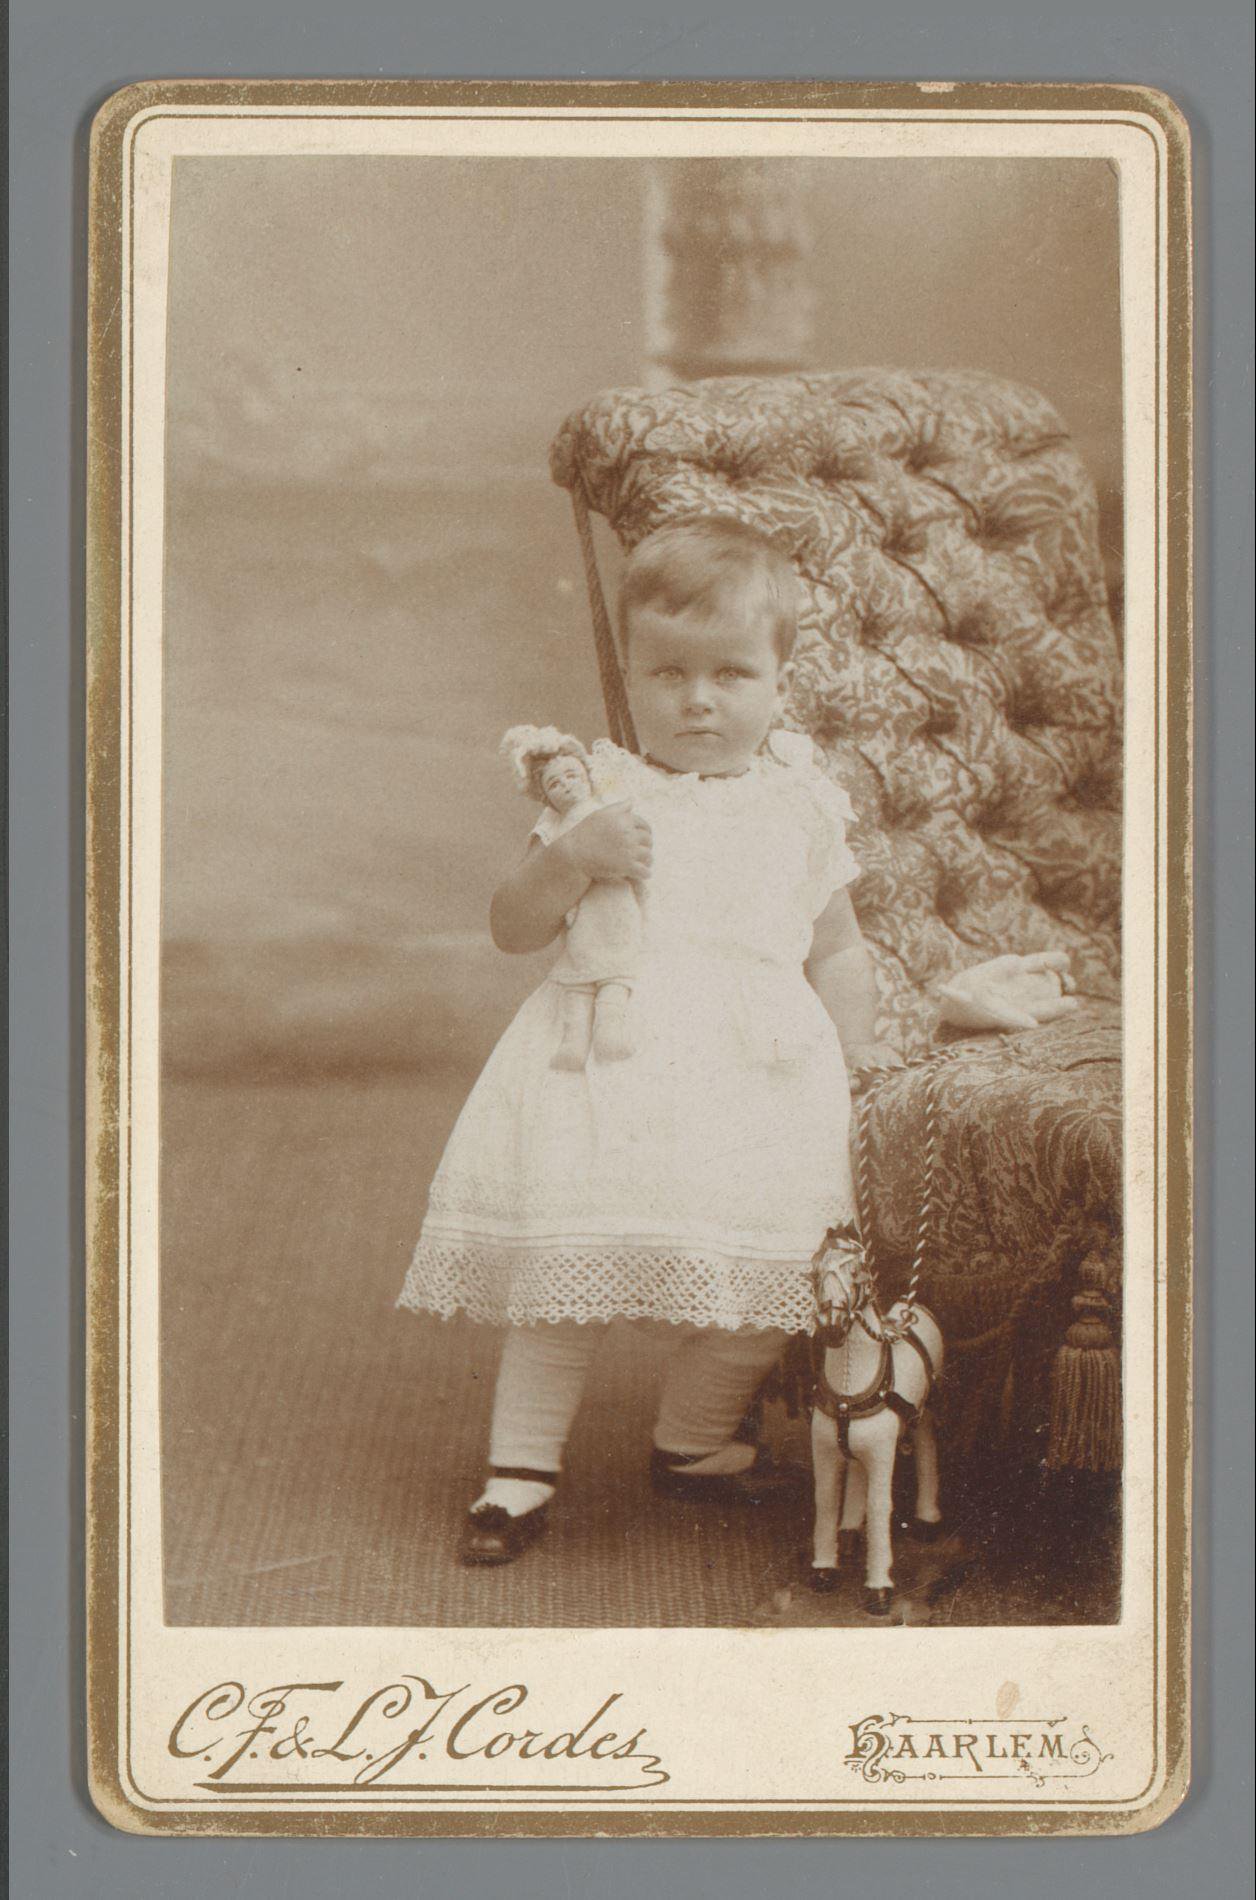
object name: photograph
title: Portret van Johanna Geertruida Jonker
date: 1897-1898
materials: cardboard, photographic support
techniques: collodion silver print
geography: haarlem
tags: historical persons, haarlem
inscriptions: workshop stamp: ‘C.F. & L.J. Cordes/ Haarlem, Groote Houtstraat 84/ 's Bosch a/d. Parade’, annotation: ‘Hansje Jonker’